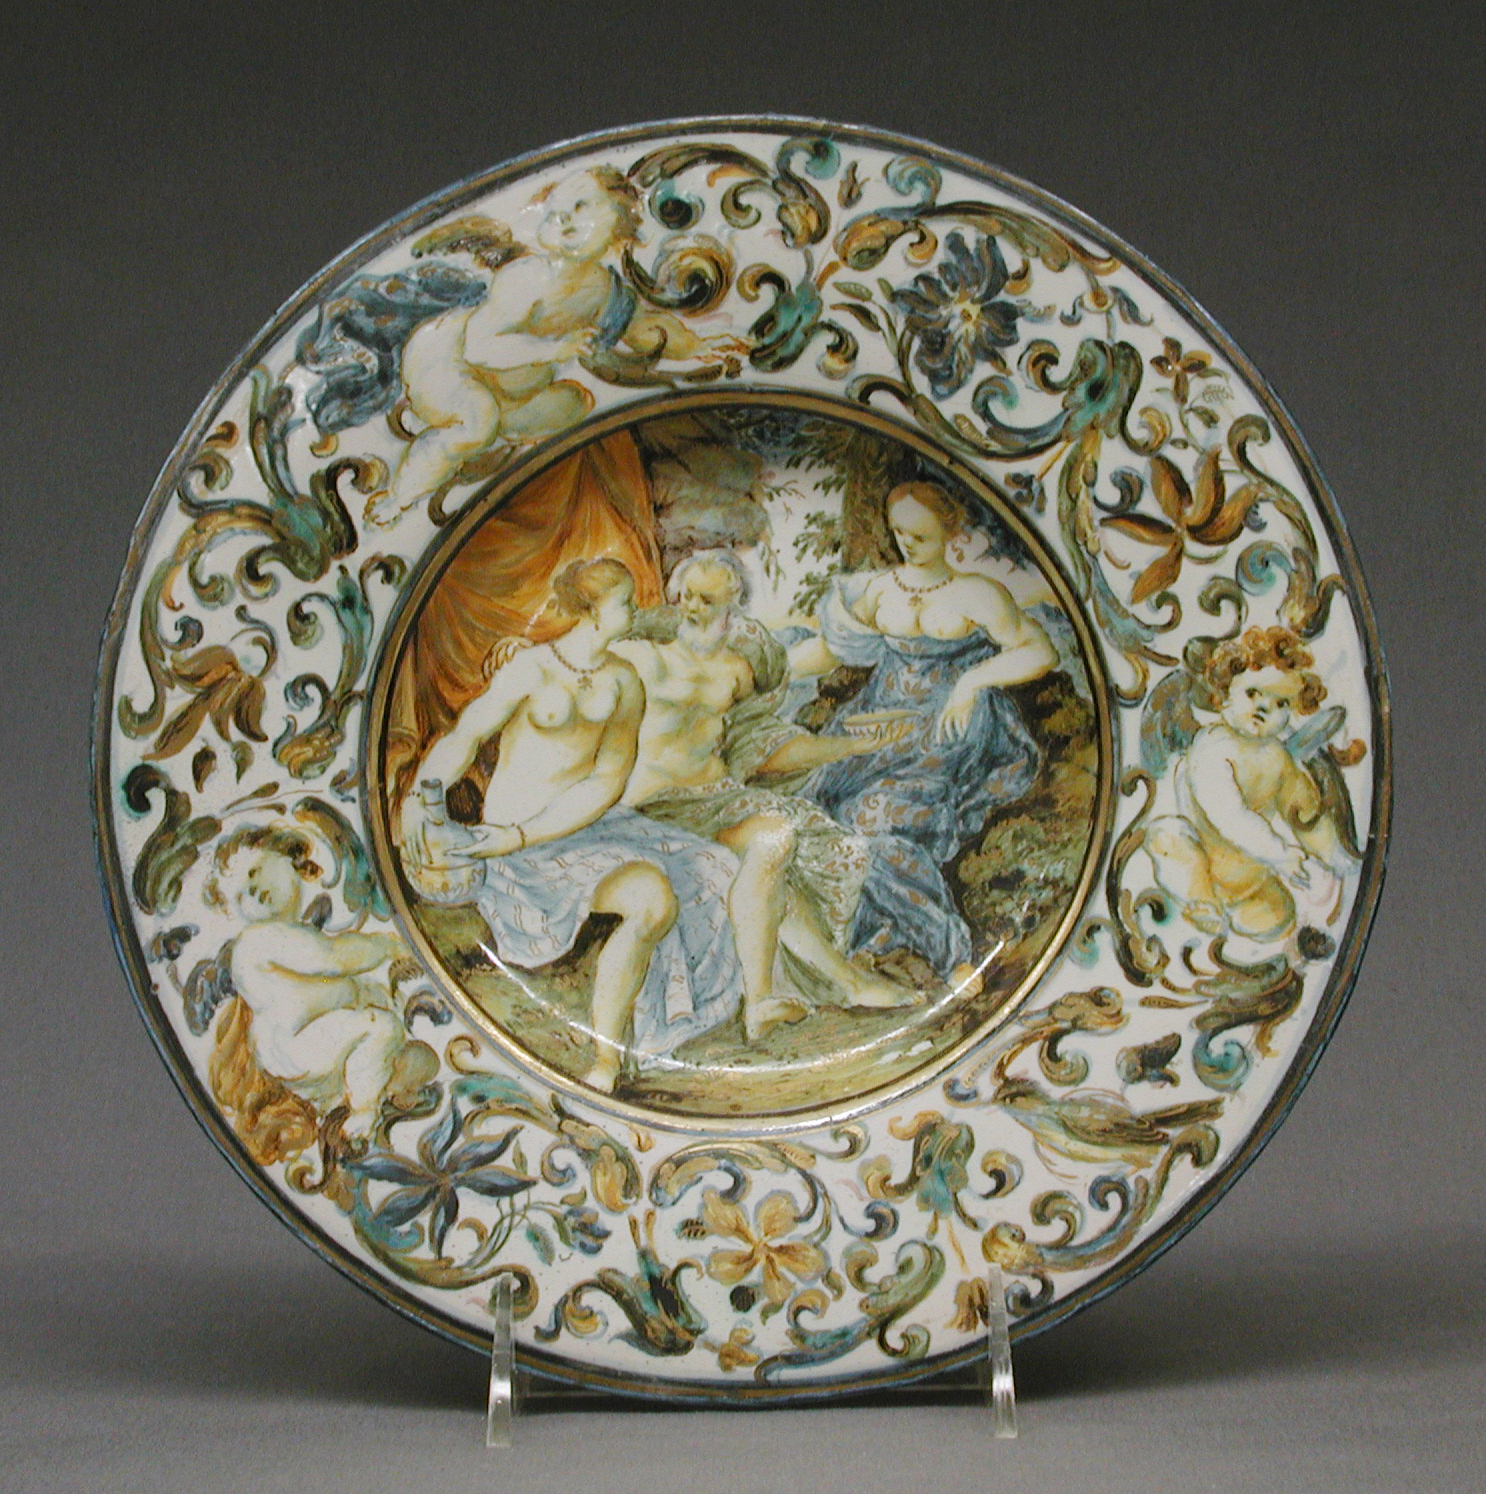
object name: plate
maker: francesco grue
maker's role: maker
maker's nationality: italian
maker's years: 1618-1673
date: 1670-1679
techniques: maiolica, glazing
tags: men,female nudes,cupid